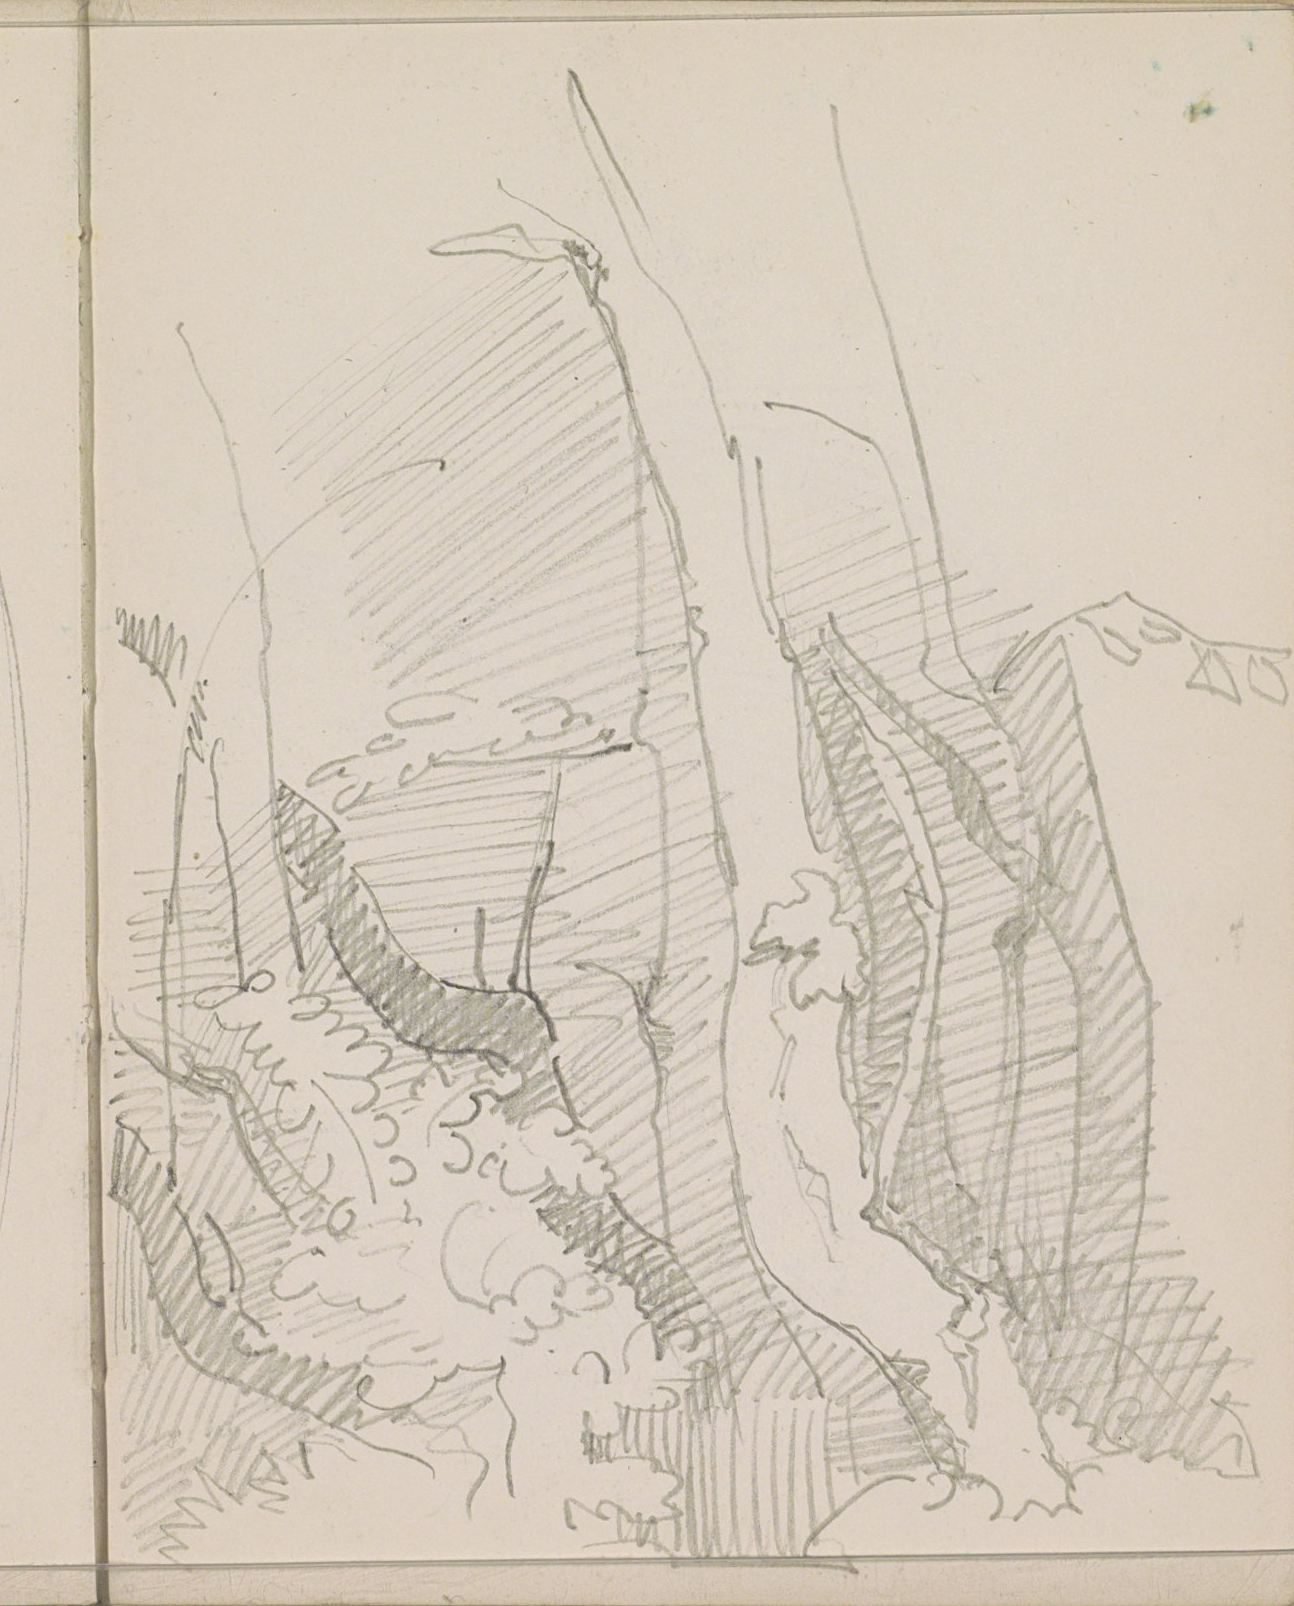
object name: sketchbook leaf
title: Boomstammen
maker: reijer stolk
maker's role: draughtsman, print maker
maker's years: 1896-1945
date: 1916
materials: paper, pencil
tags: trees (+ stem, trunk)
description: Blad 57 recto uit een schetsboek met 72 bladen.